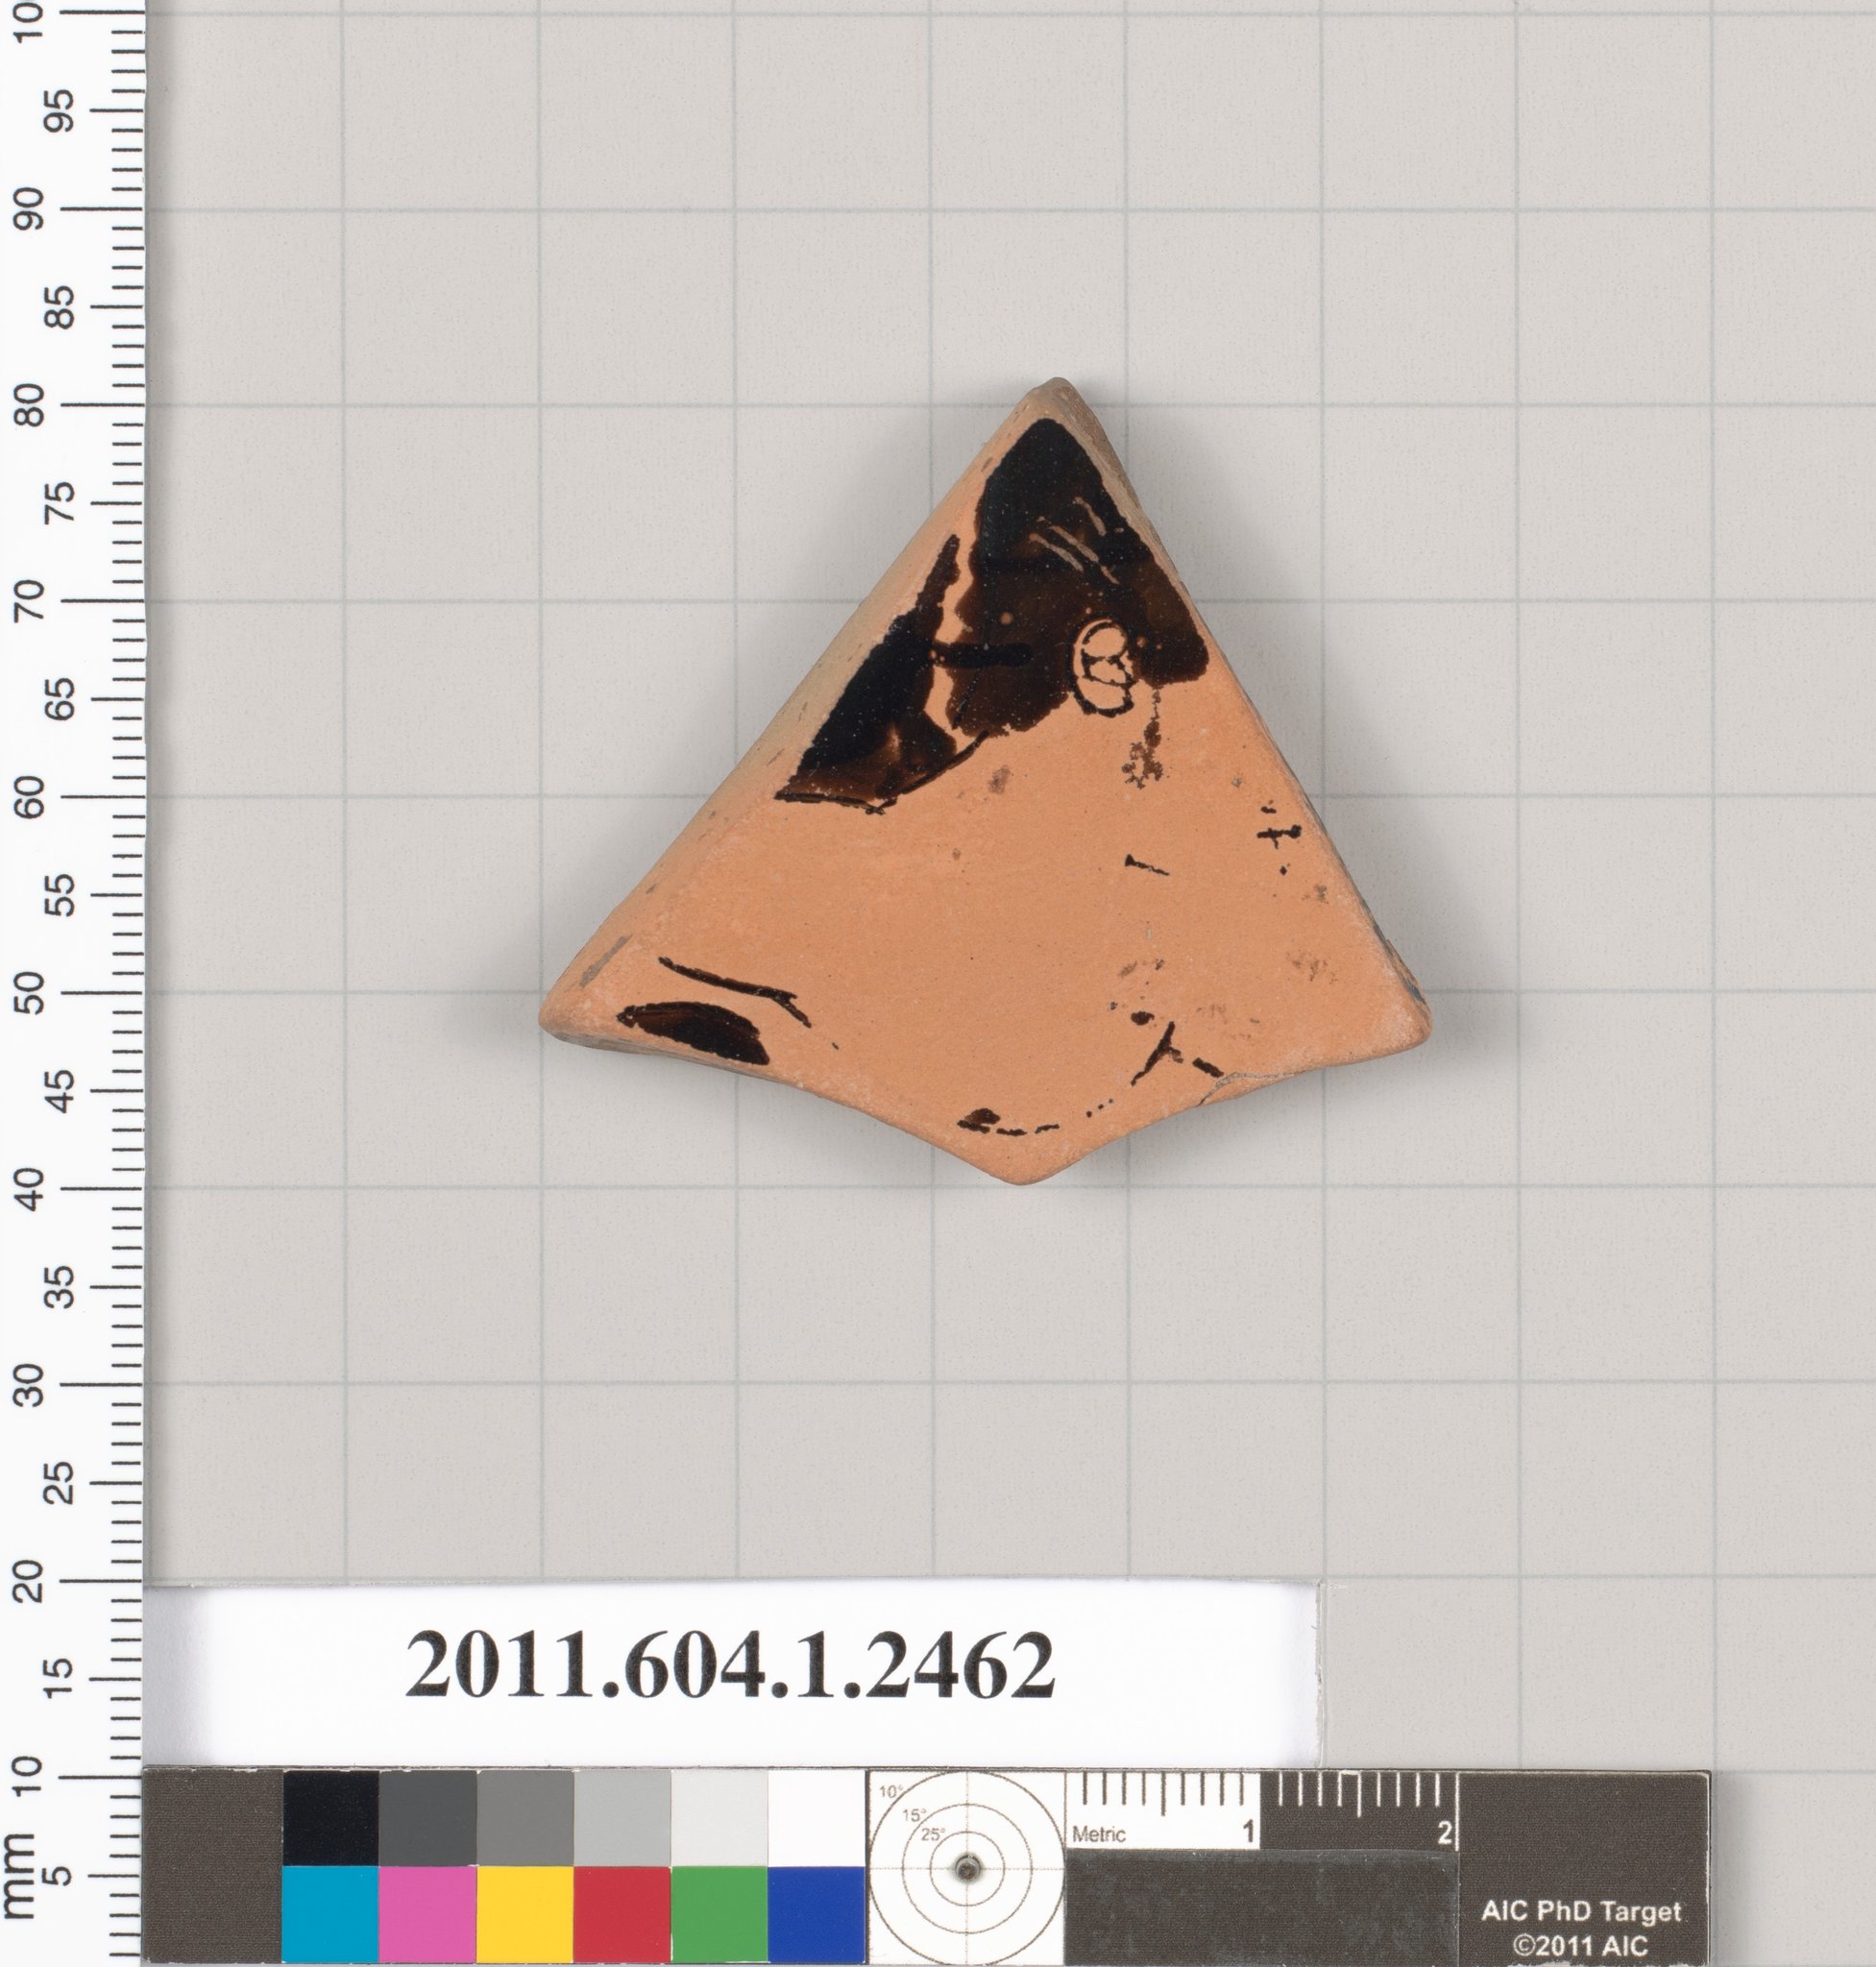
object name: kylix fragment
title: Terracotta fragment of a kylix (drinking cup)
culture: greek, attic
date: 510-490 BCE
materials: terracotta